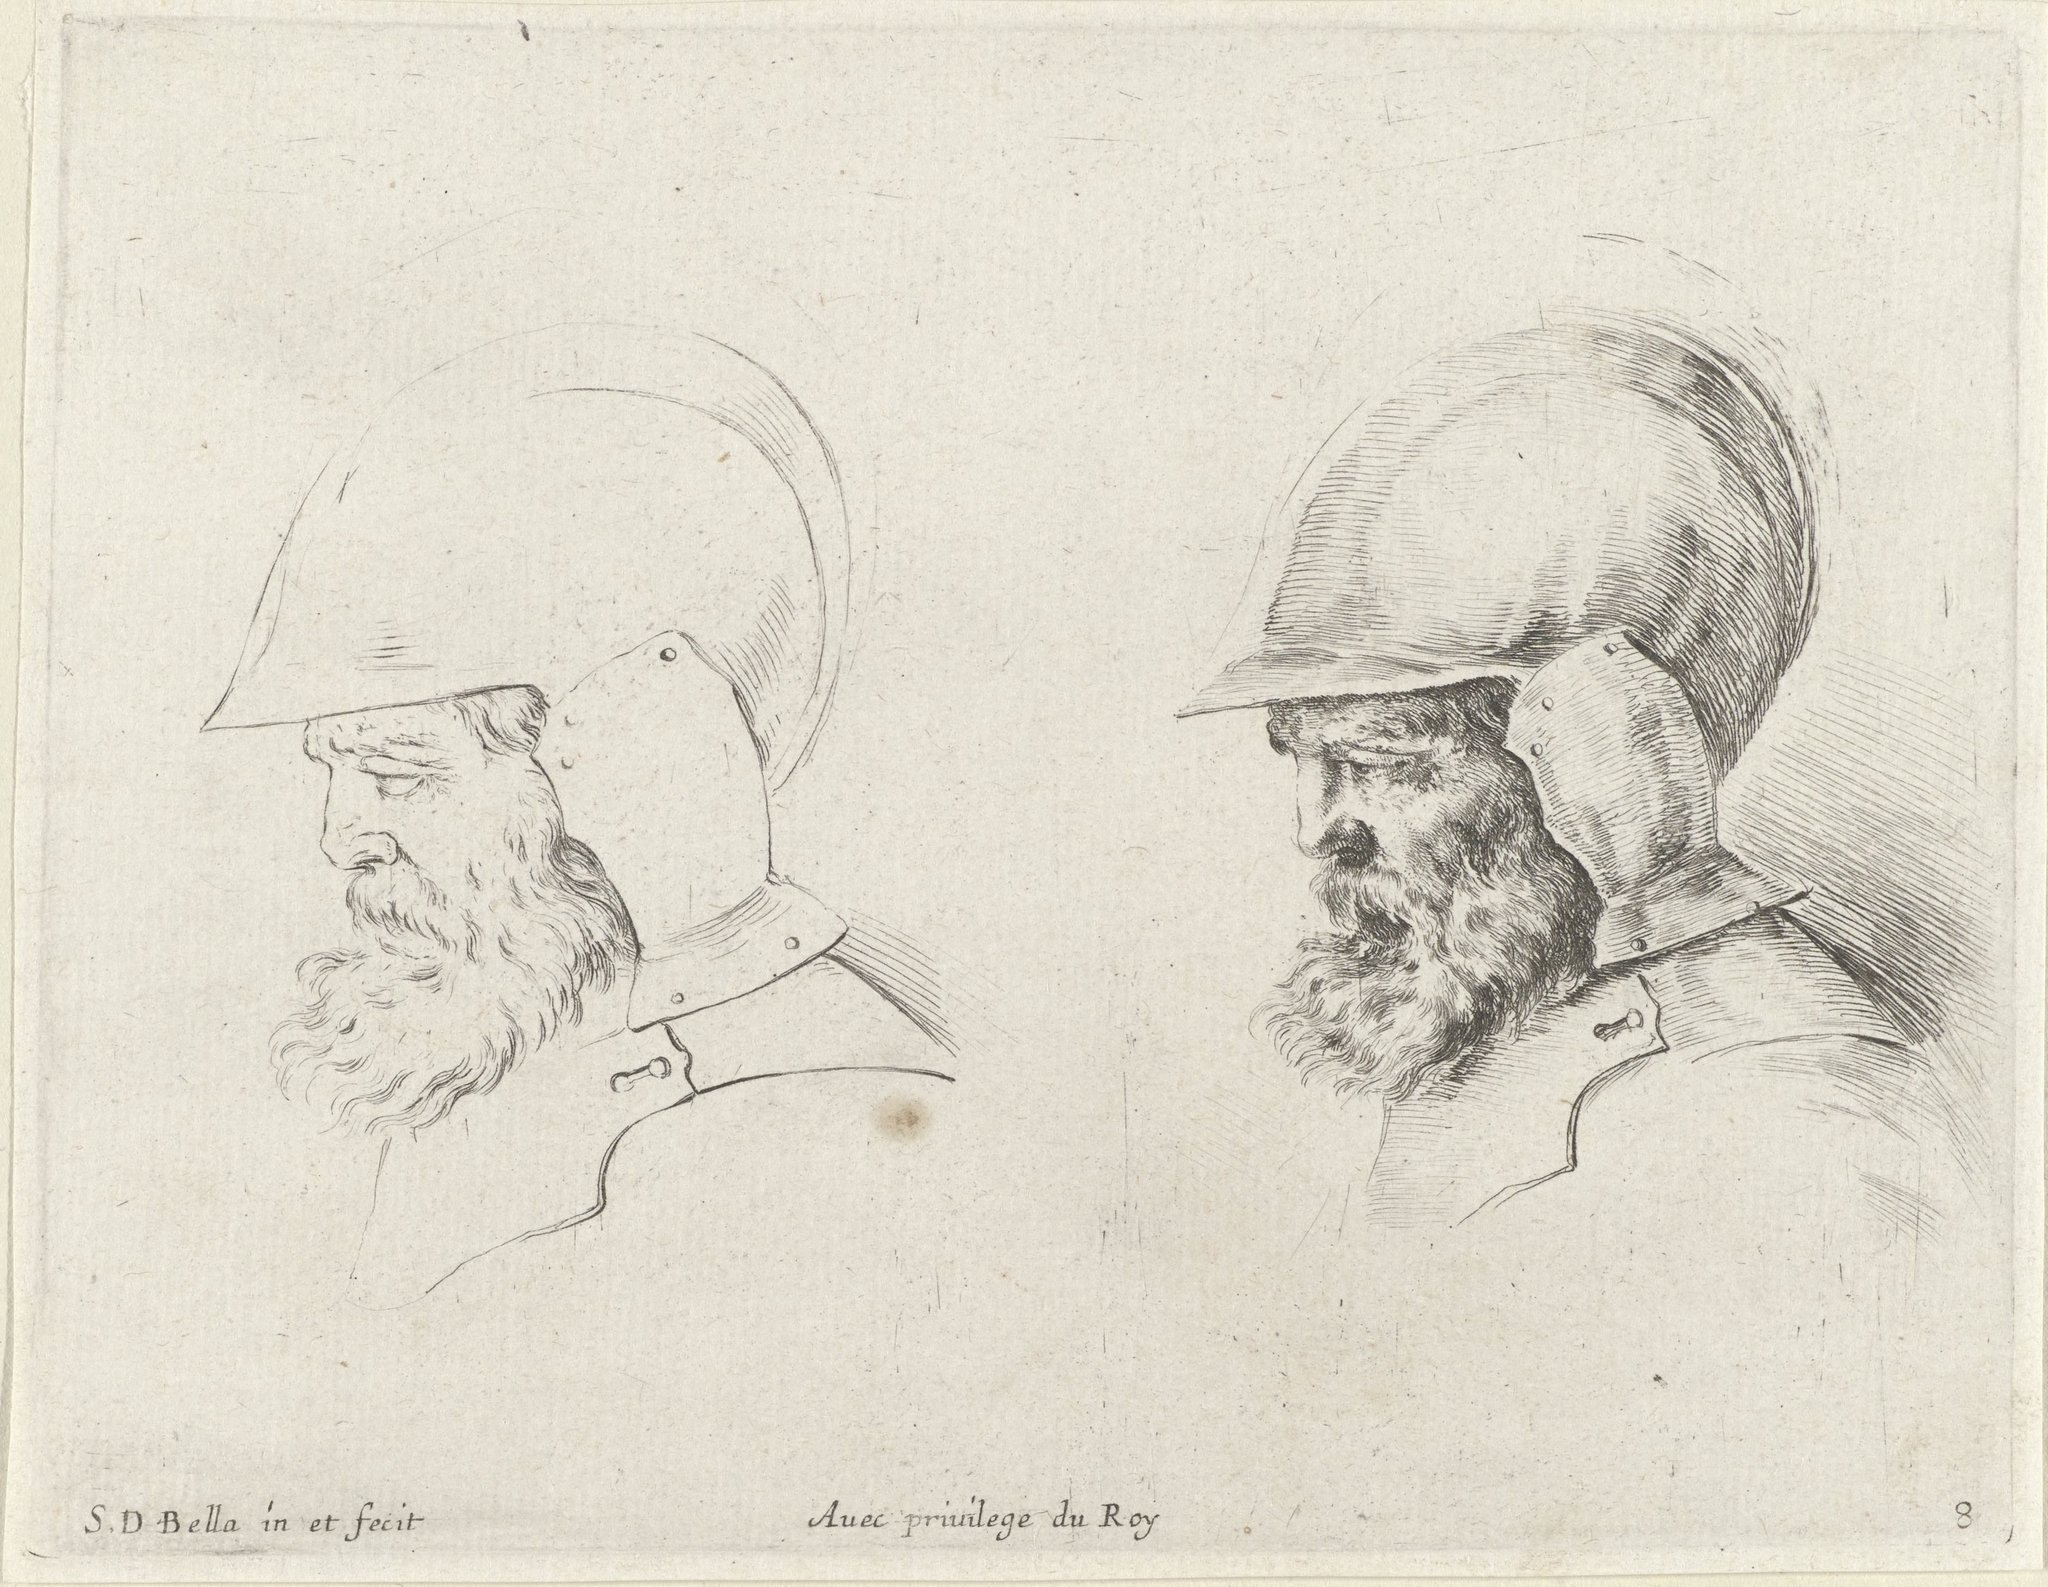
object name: print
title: Twee keer hetzelfde hoofd van een soldaat met helm in profiel naar links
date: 1620-1664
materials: paper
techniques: etching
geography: france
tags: helmet, head (human) (+ sideview, profile), the soldier; the soldier's life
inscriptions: collector's mark: Lugt 240